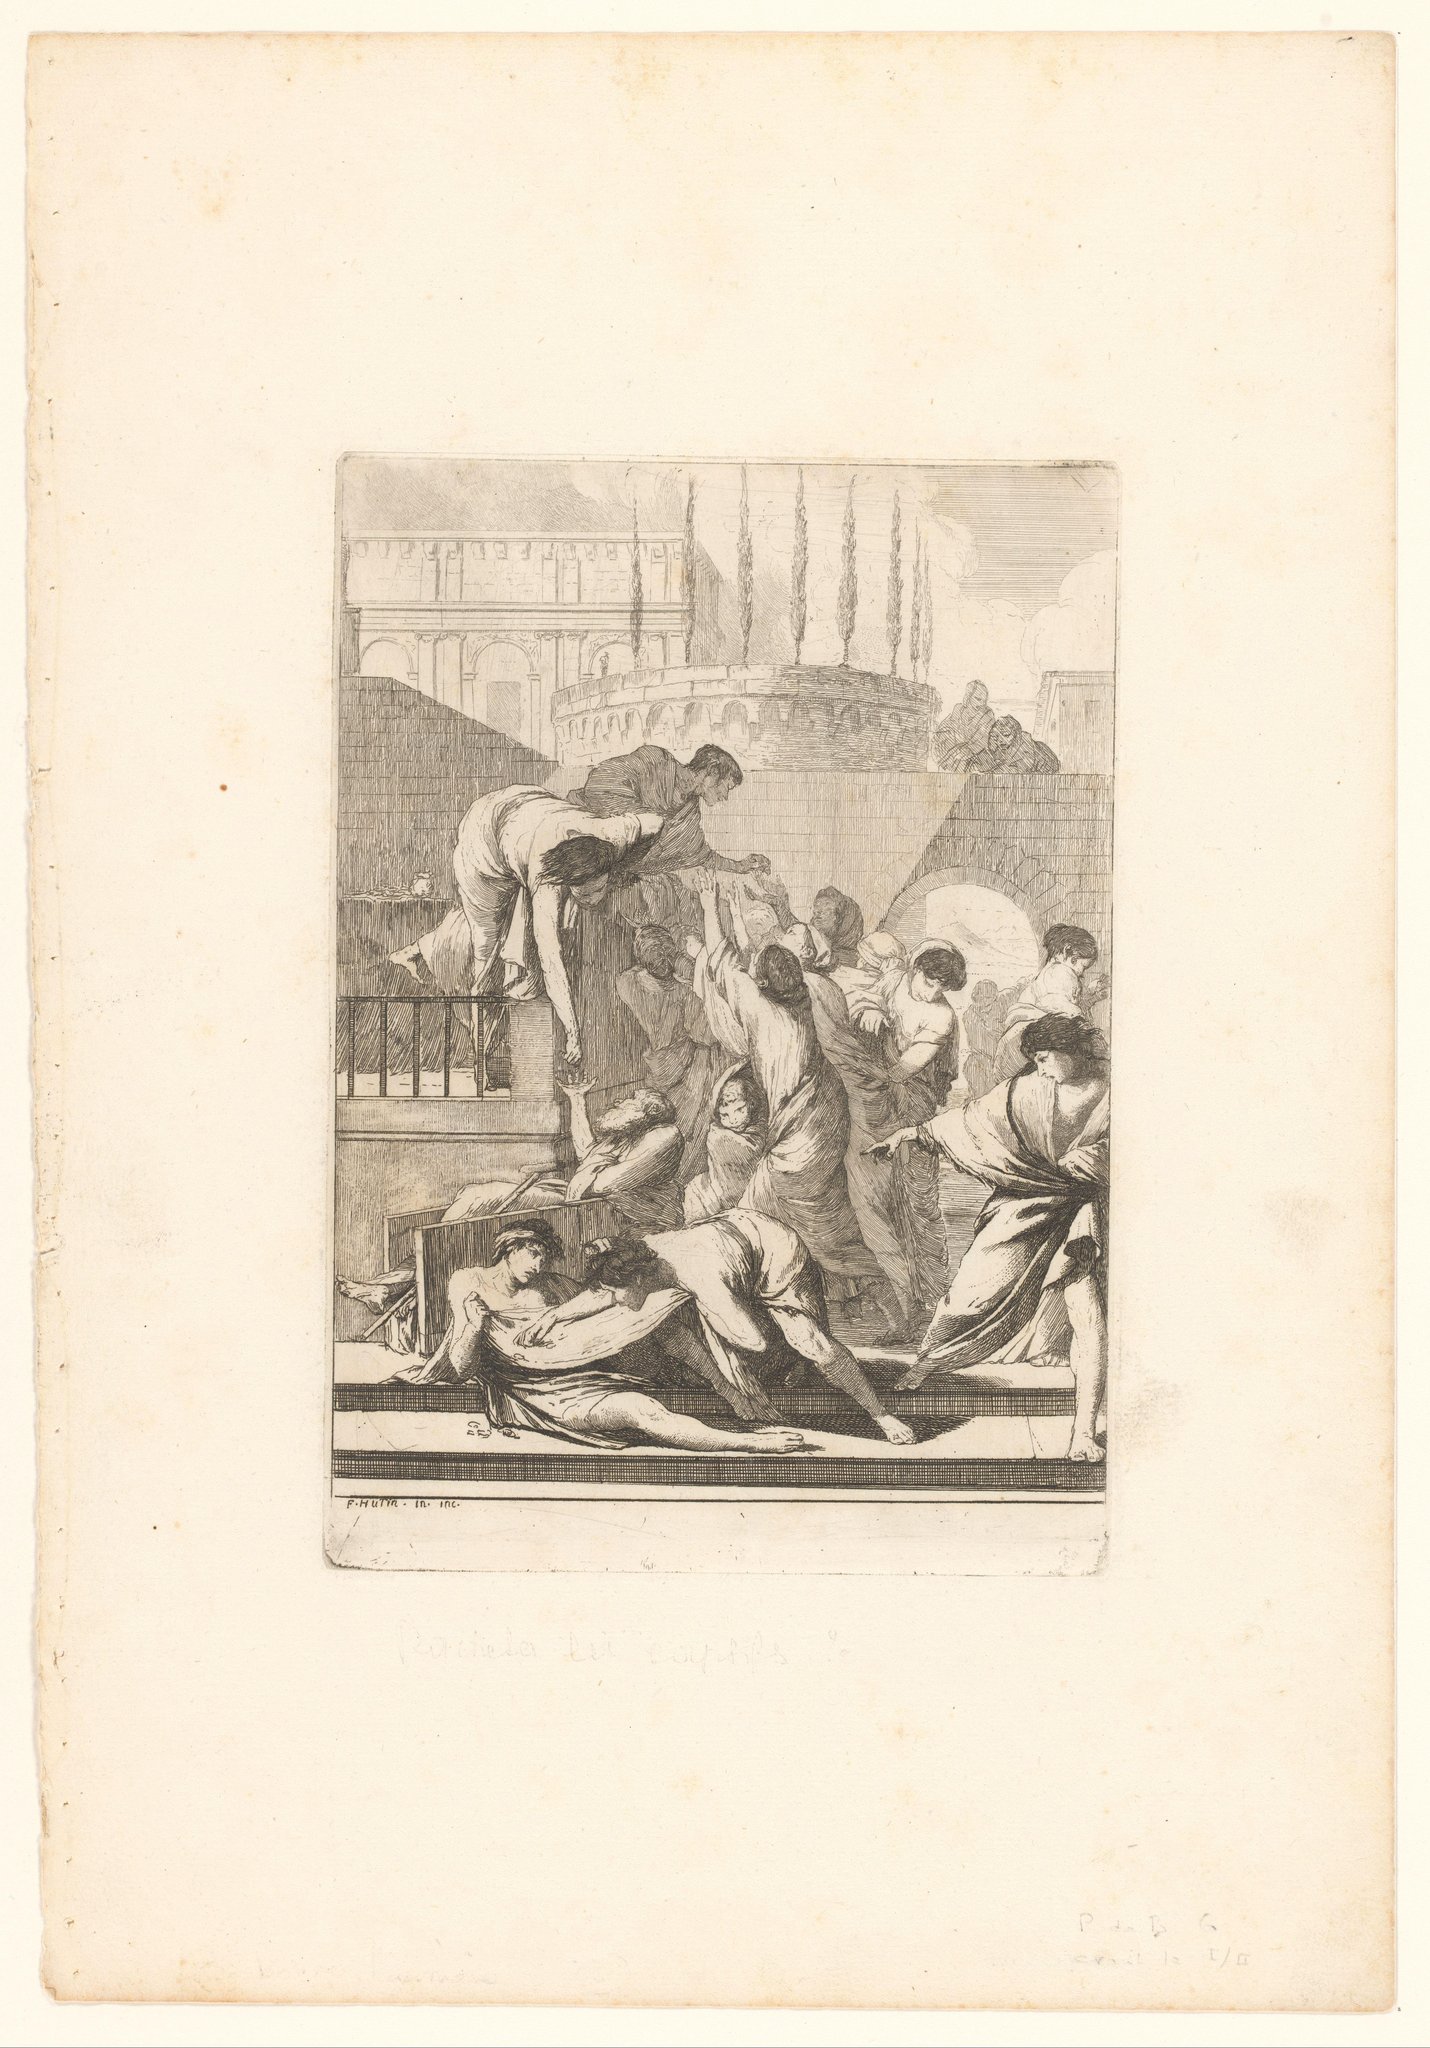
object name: print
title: De zeven werken van barmhartigheid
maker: françois hutin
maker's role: painter, print maker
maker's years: 1685-1758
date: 1730-1750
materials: paper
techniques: etching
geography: dresden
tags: sheltering strangers, 'hospes colligitur' ~ one of the (seven) acts of mercy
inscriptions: collector's mark: Lugt 2760, collector's mark, collector's mark: Lugt 2228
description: Onderdeel van een serie van zeven werken van barmhartigheid met voorstellingen in antieke setting.